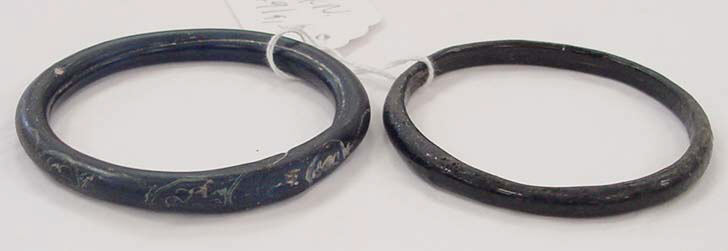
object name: jewelry set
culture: italian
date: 1801-1900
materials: glass, stone